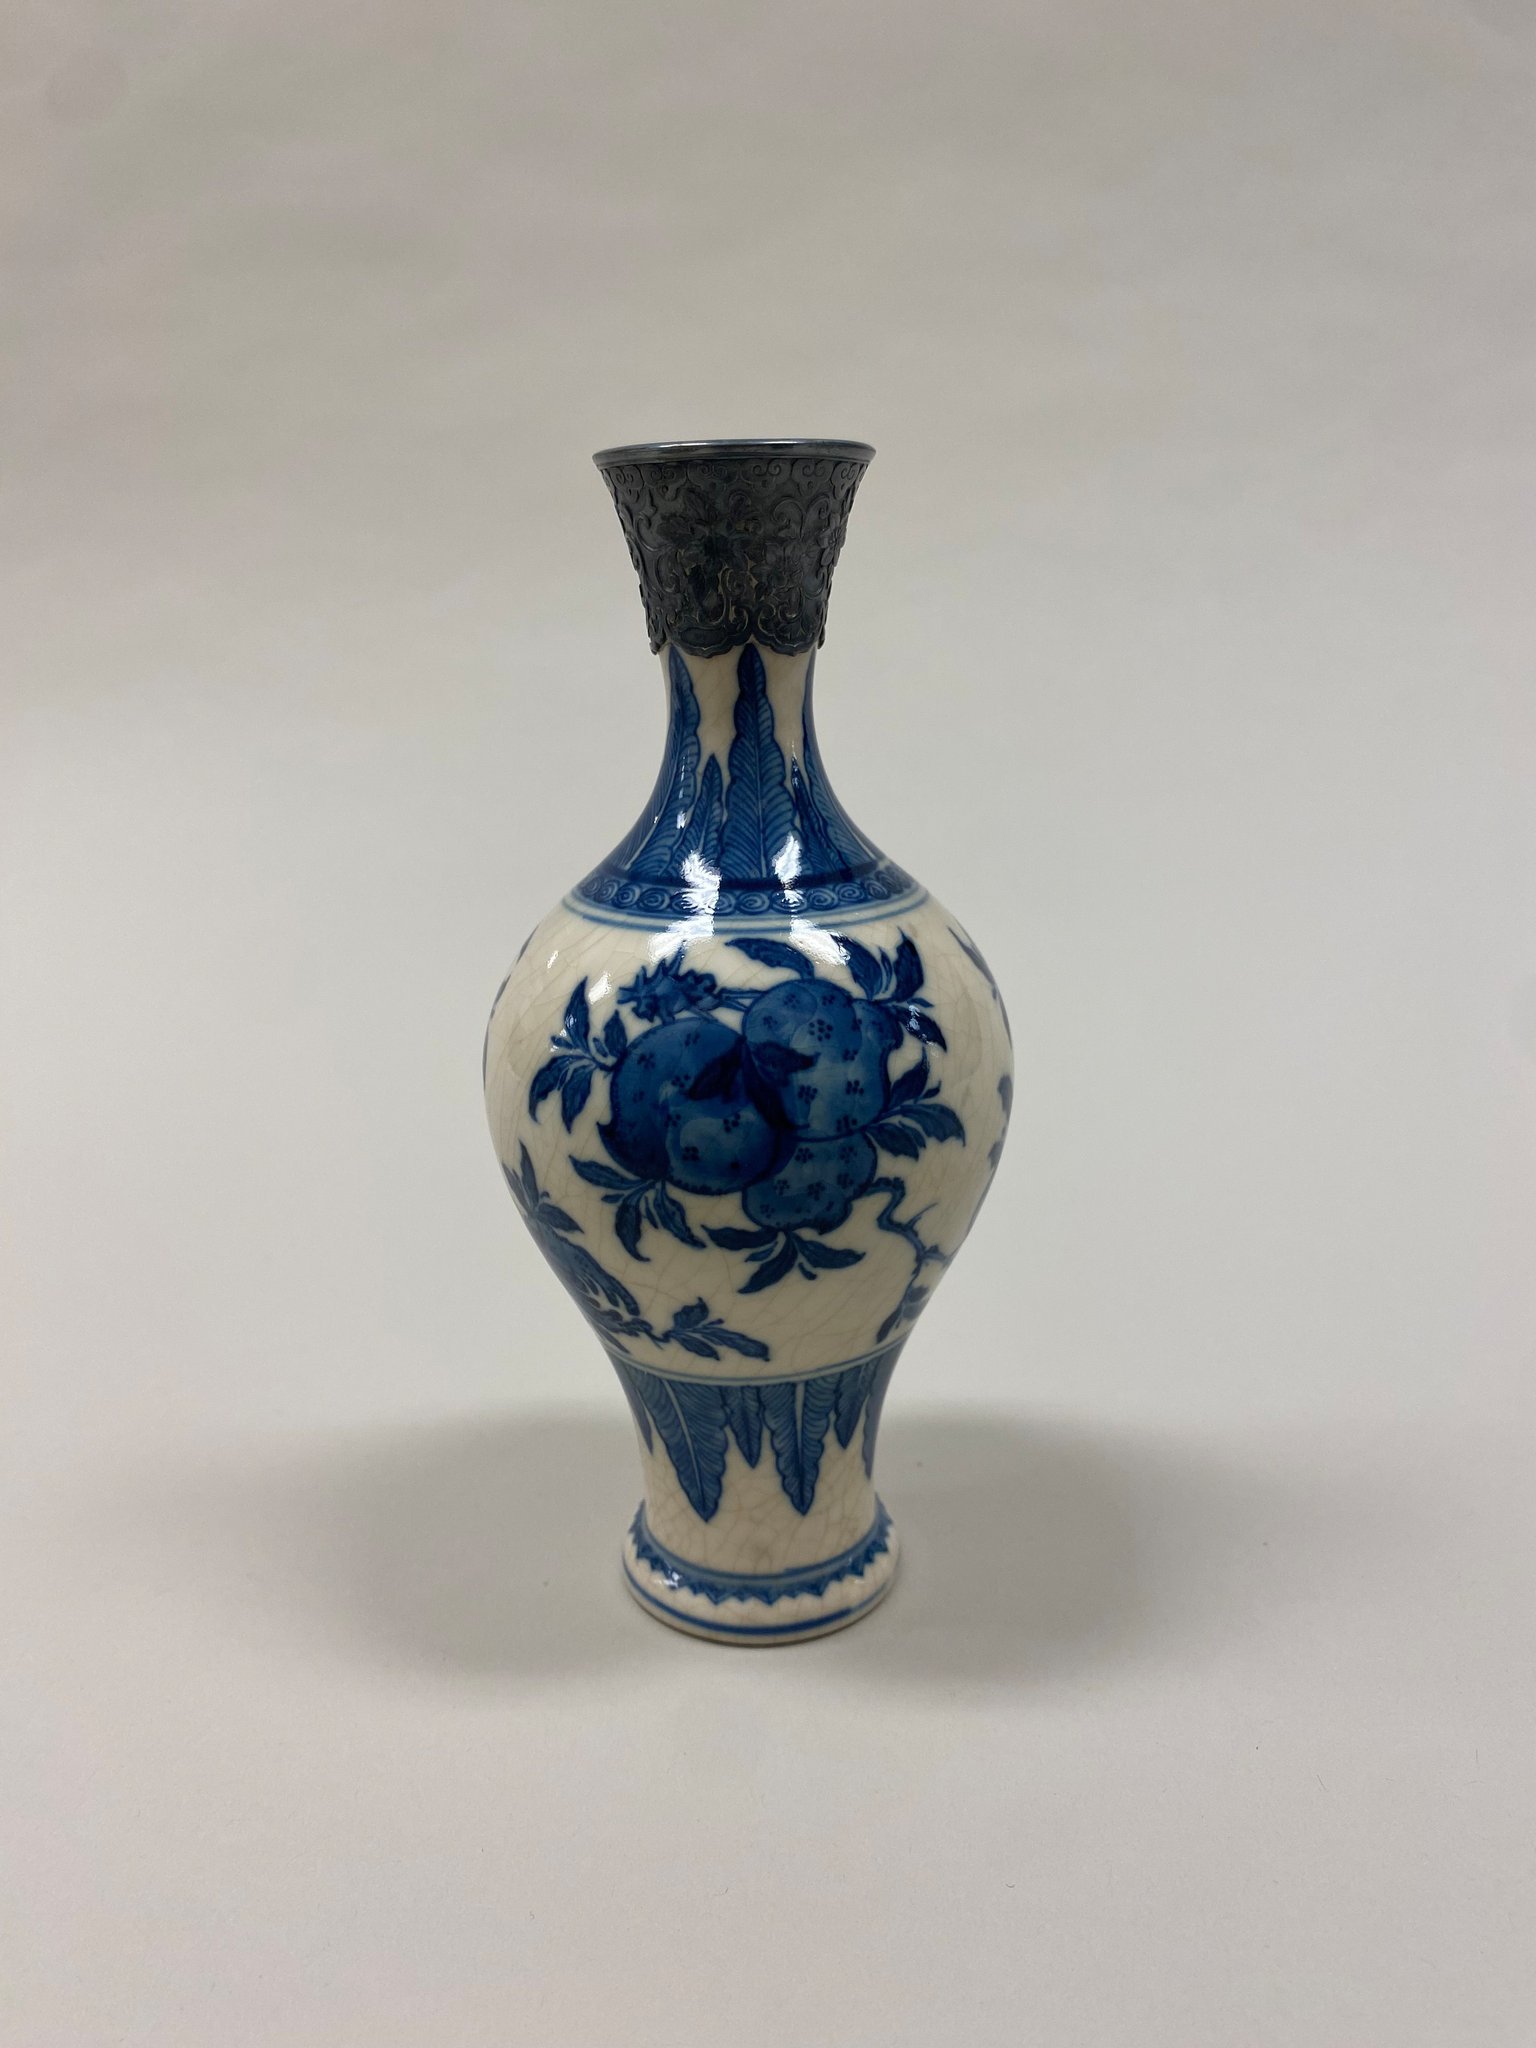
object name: vase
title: Vase with peaches, pomegranates, and fingered citrons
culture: chinese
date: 1701-1733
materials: cobalt, silver, soft paste porcelain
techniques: painting, underglaze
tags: fruit